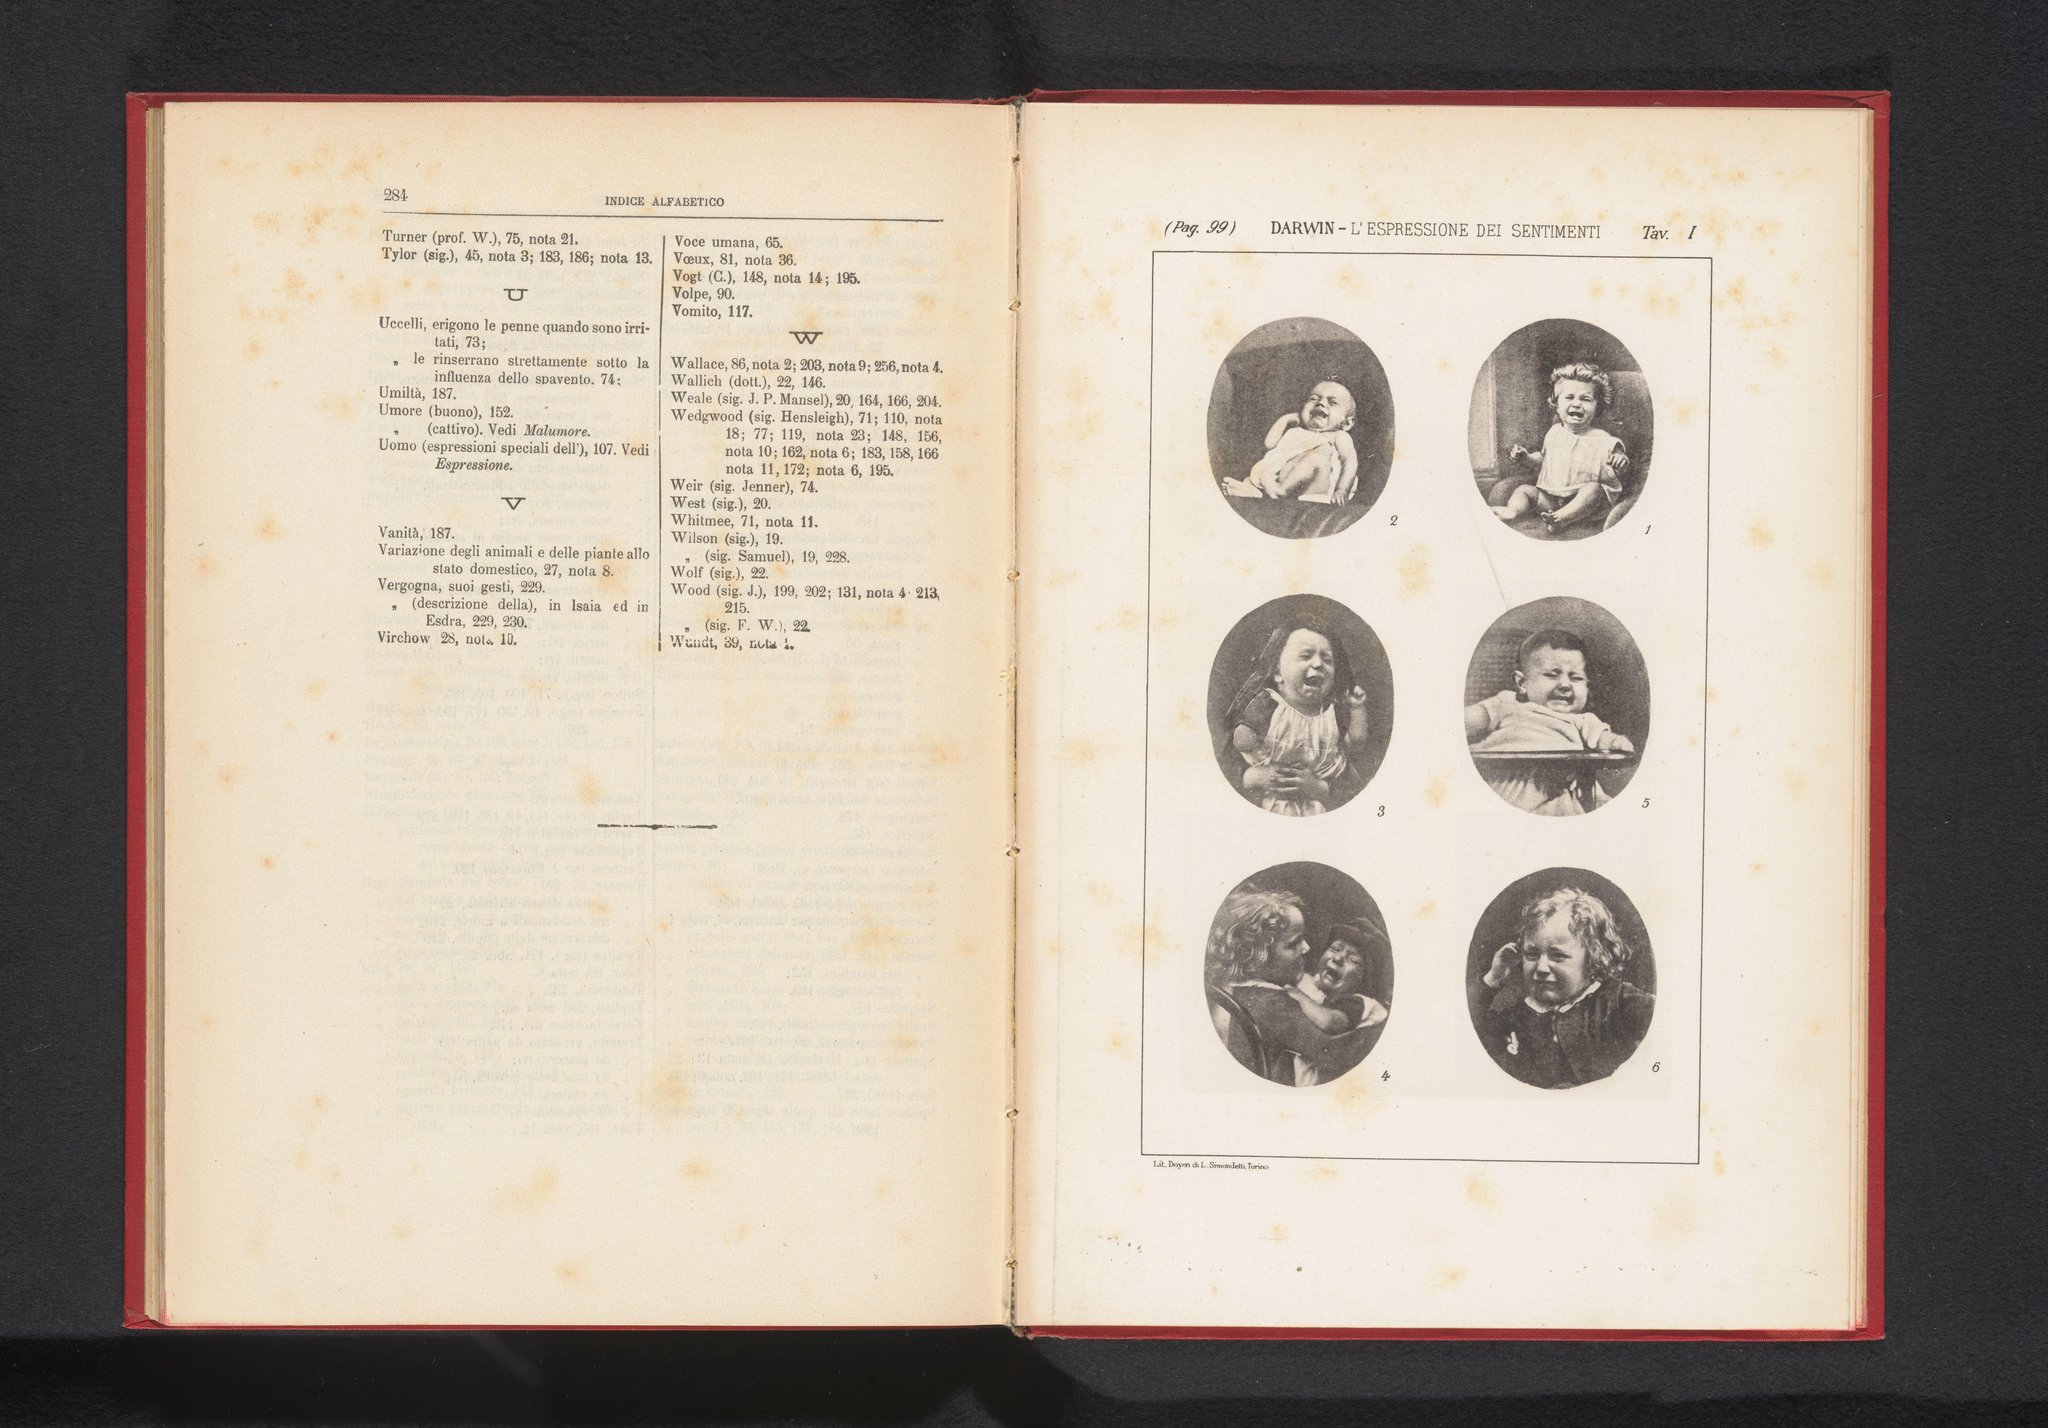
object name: page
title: Zes portretten van onbekende kinderen die lijden en huilen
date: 1880-1890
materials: paper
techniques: photograph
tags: passions, emotions, affections, weeping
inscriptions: number: ‘Tav. I 1 2 3 4 5 6 (Pag. 99)’